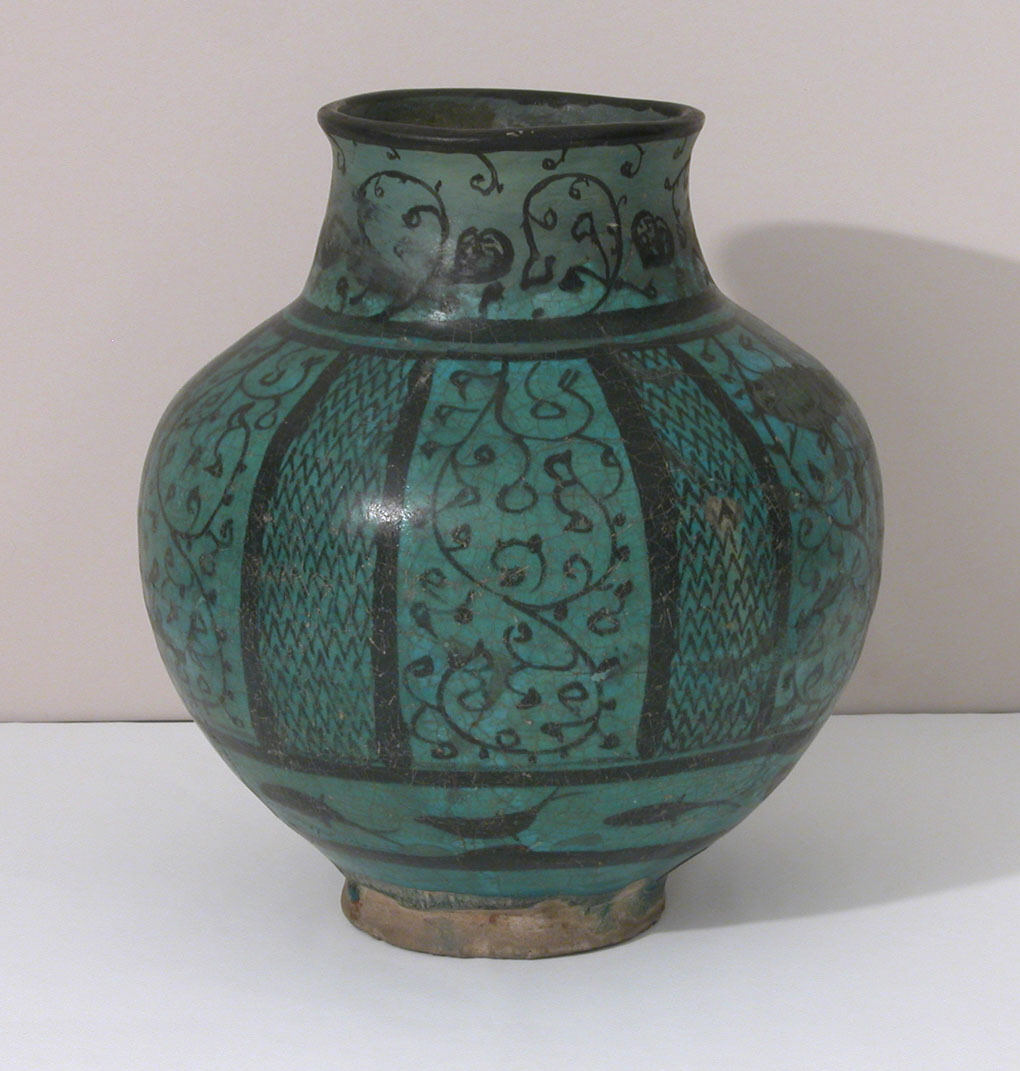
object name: jar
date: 1201-1300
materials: glaze, stonepaste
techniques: painting, underglaze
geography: syria